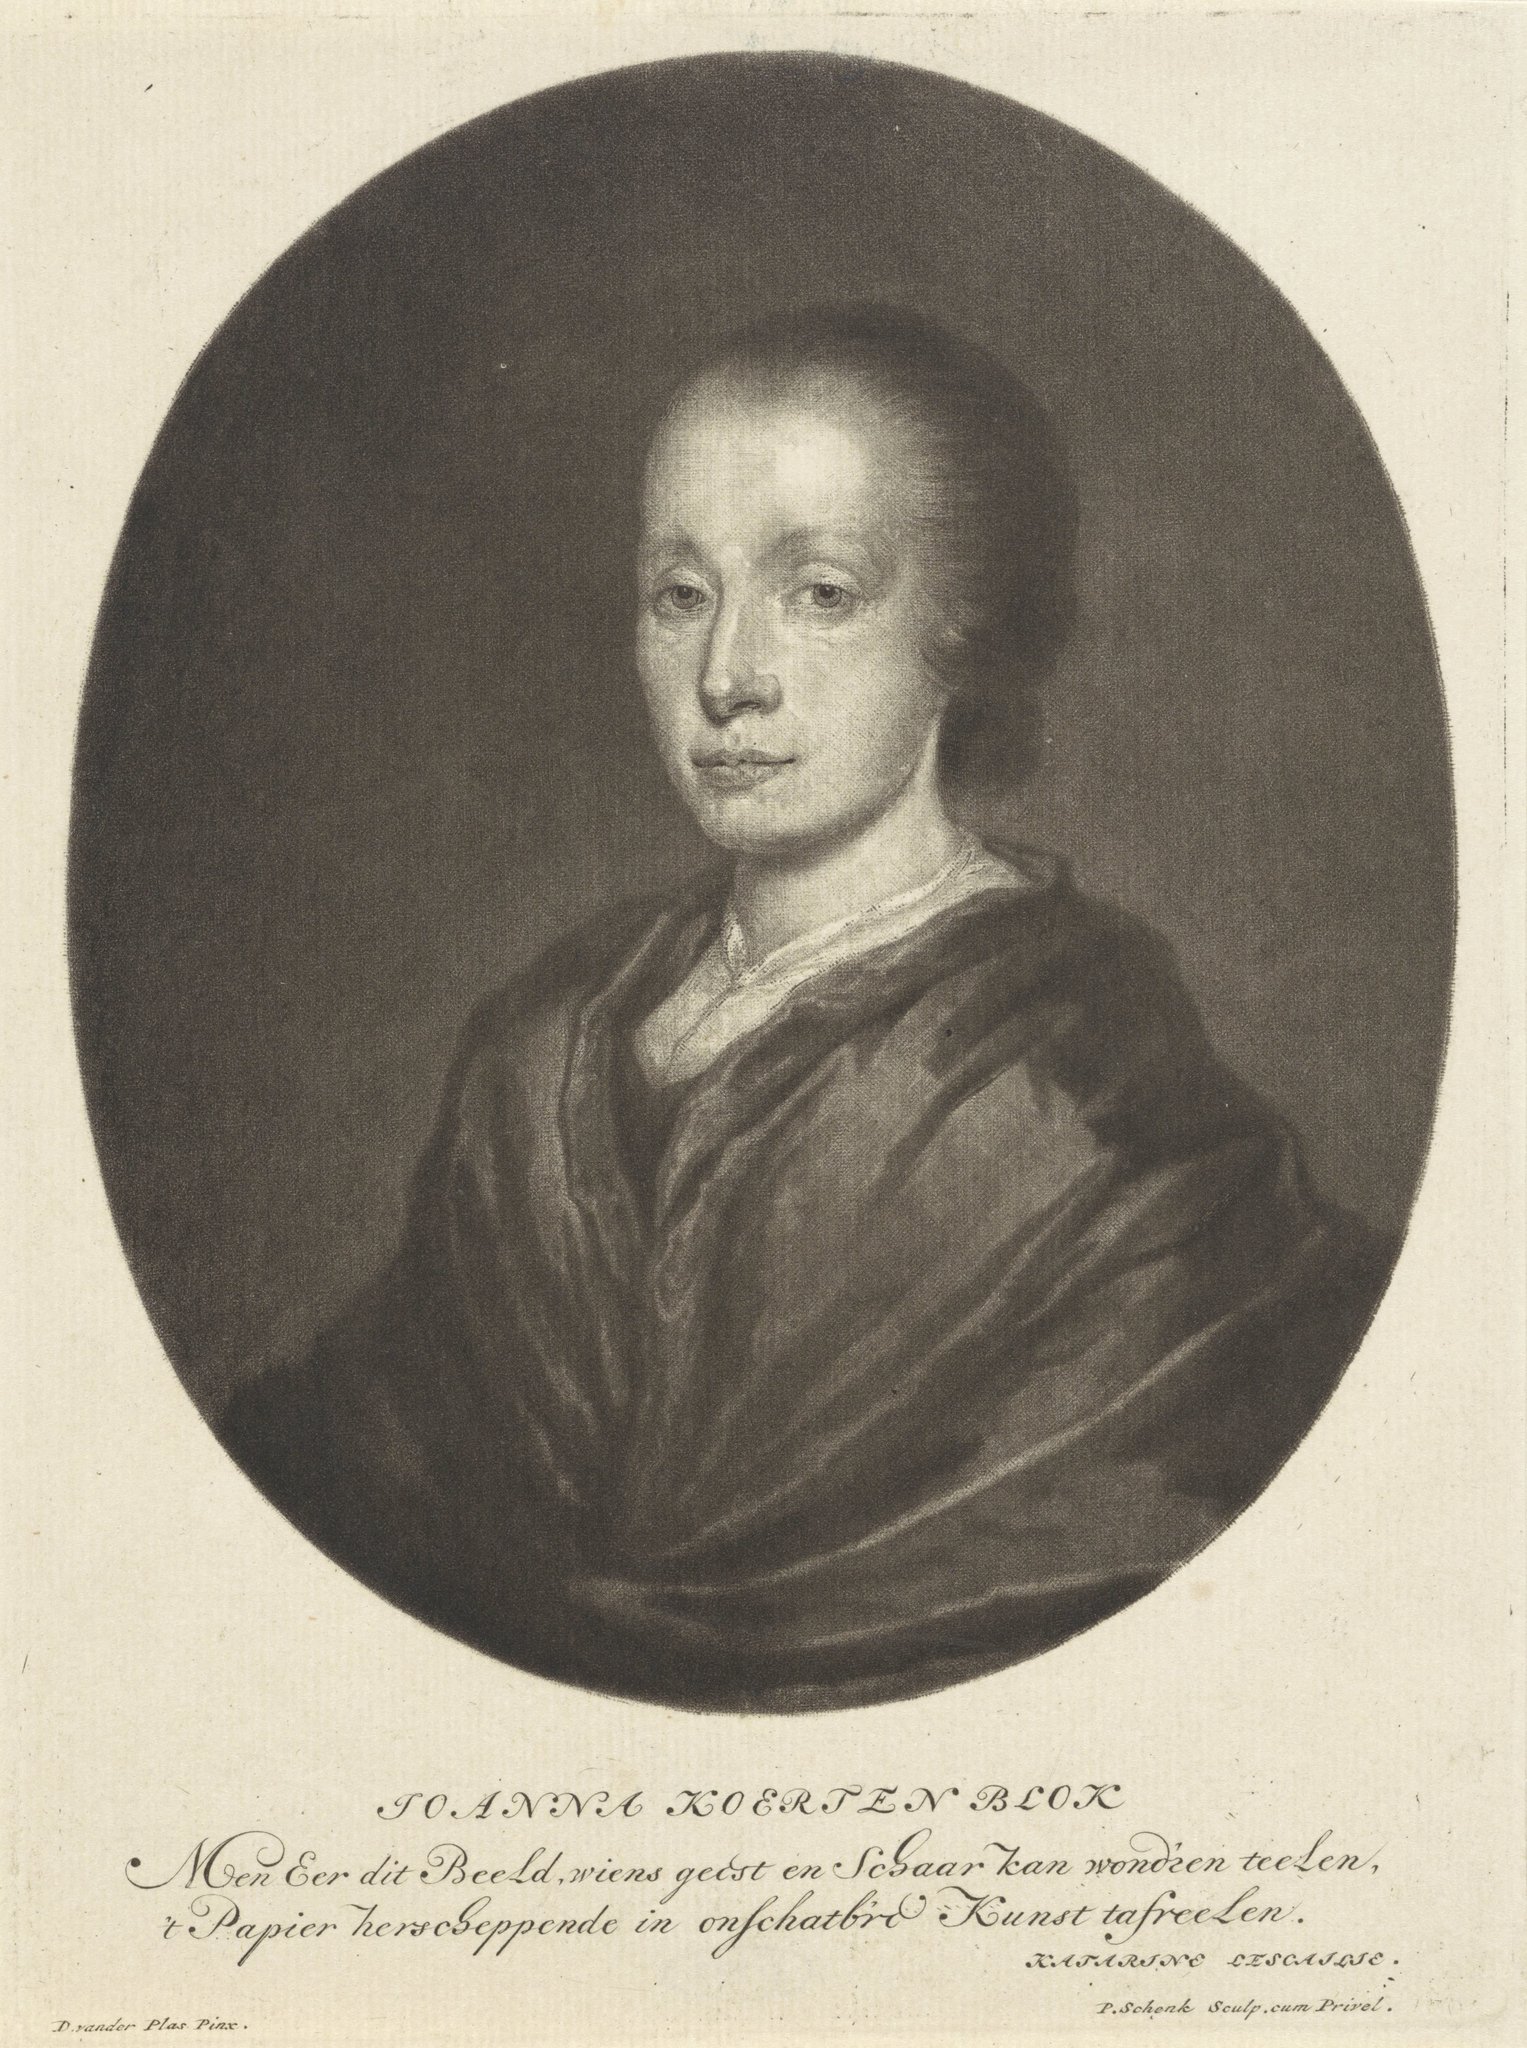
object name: print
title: Portret van de knipkunstenares Johanna Koerten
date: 1701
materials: paper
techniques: engraving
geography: amsterdam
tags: amsterdam, johanna koerten, portrait, self-portrait of artist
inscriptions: collector's mark: Lugt 964, collector's mark: Lugt 2228